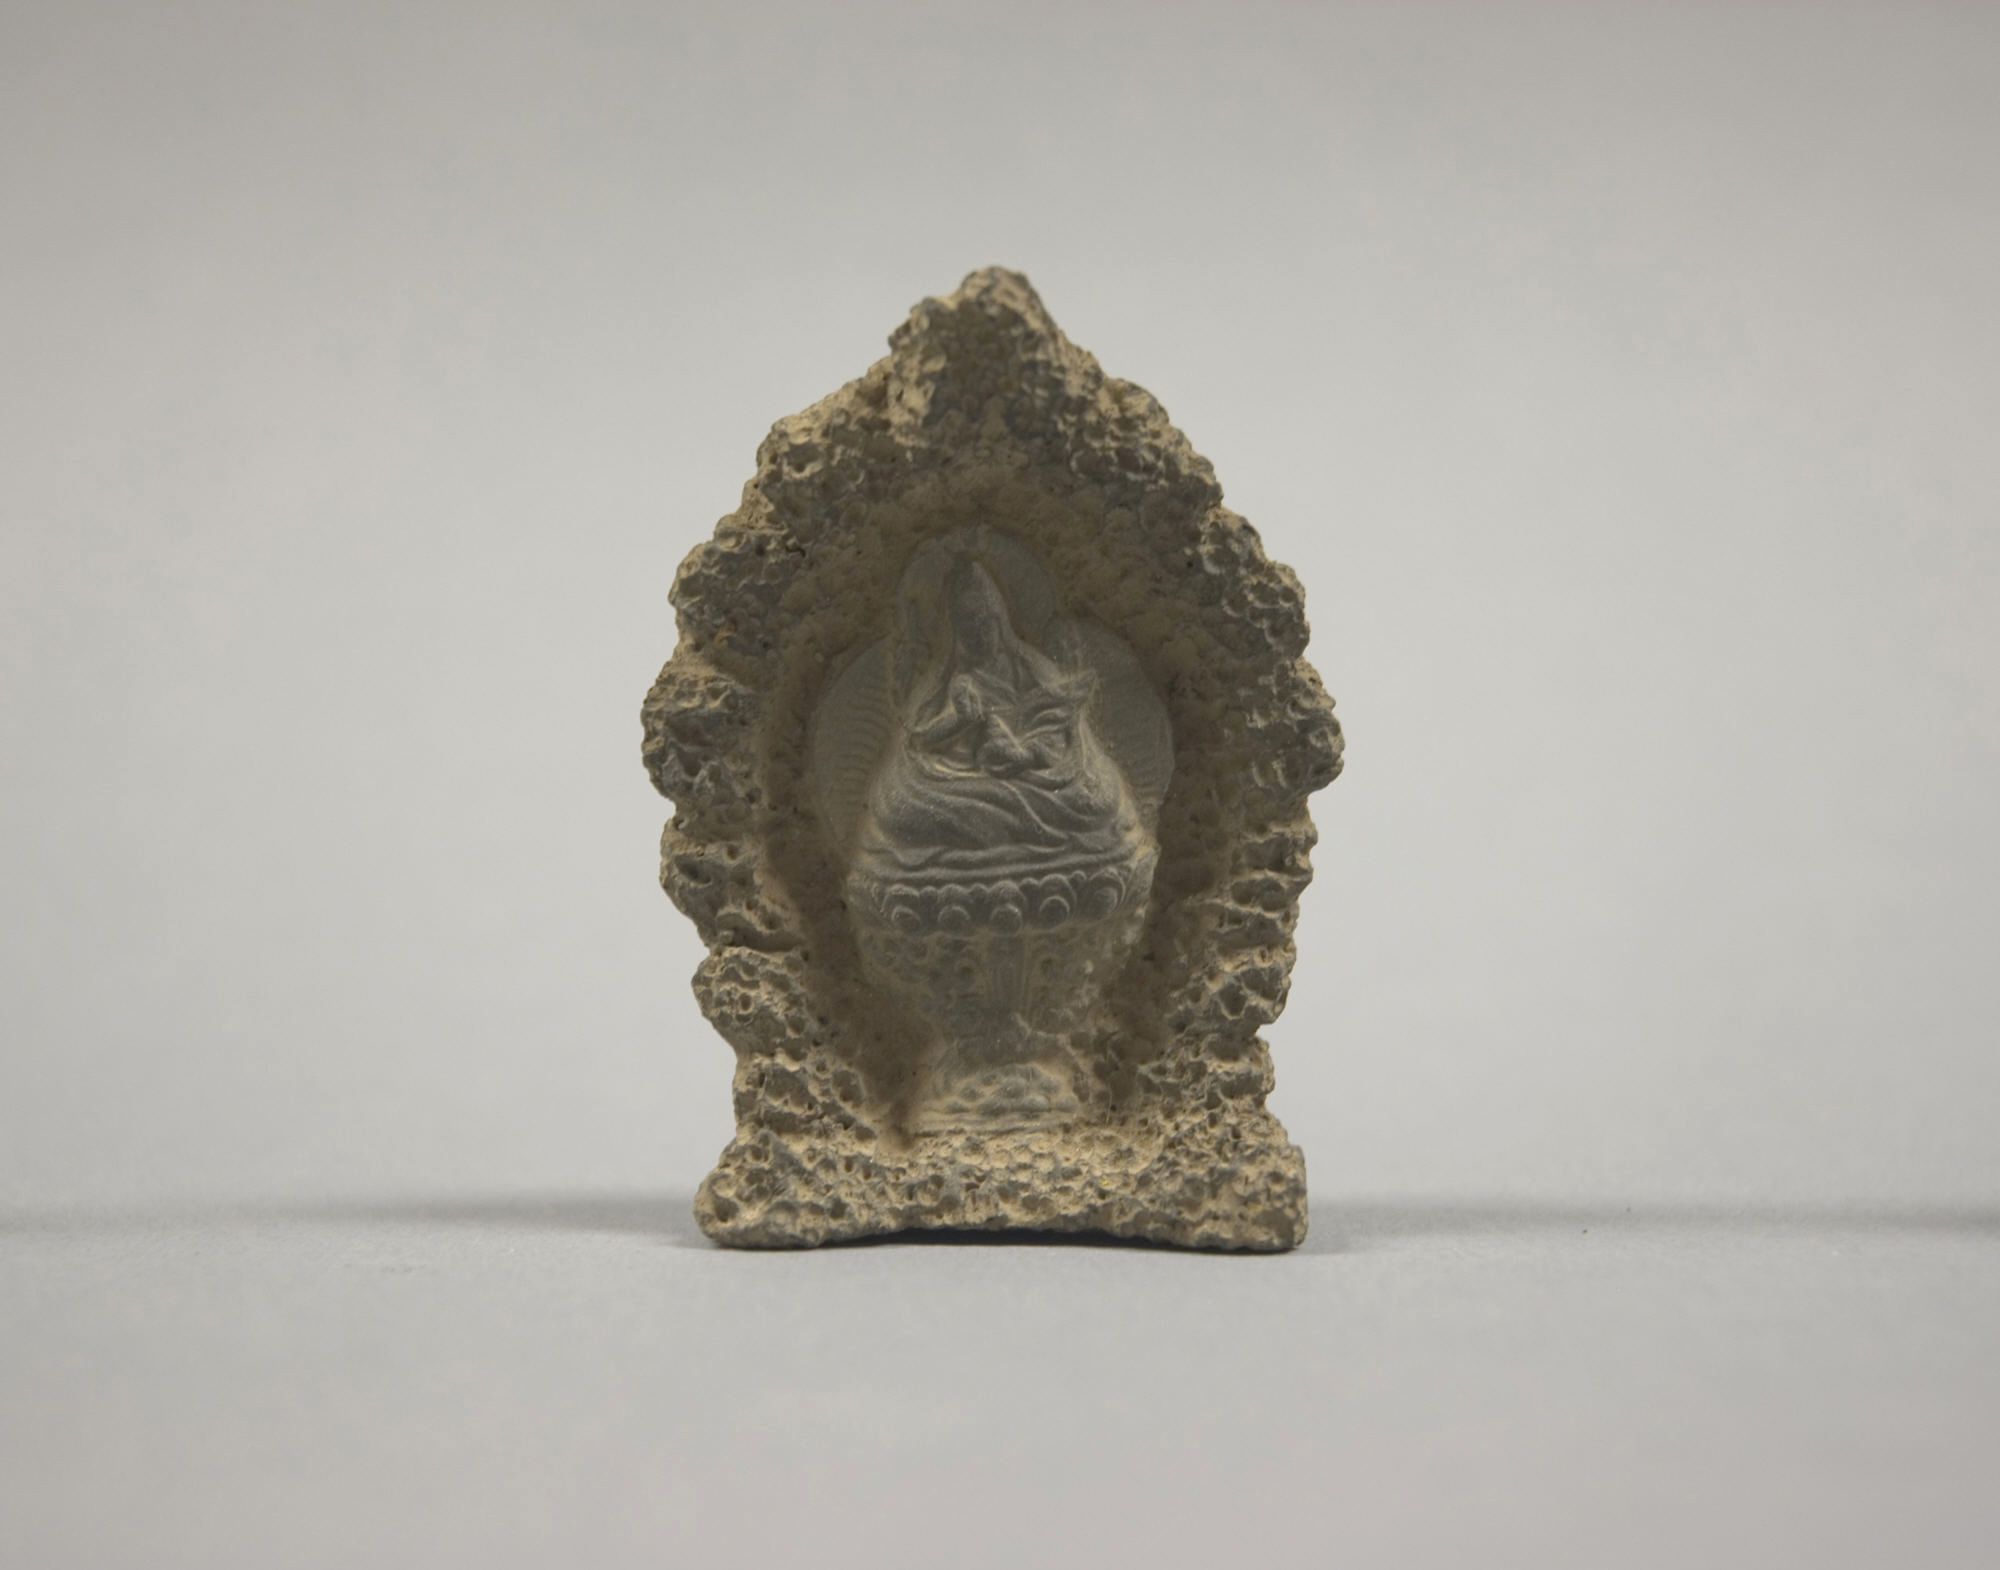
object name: votive plaque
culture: tibetan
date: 701-800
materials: clay